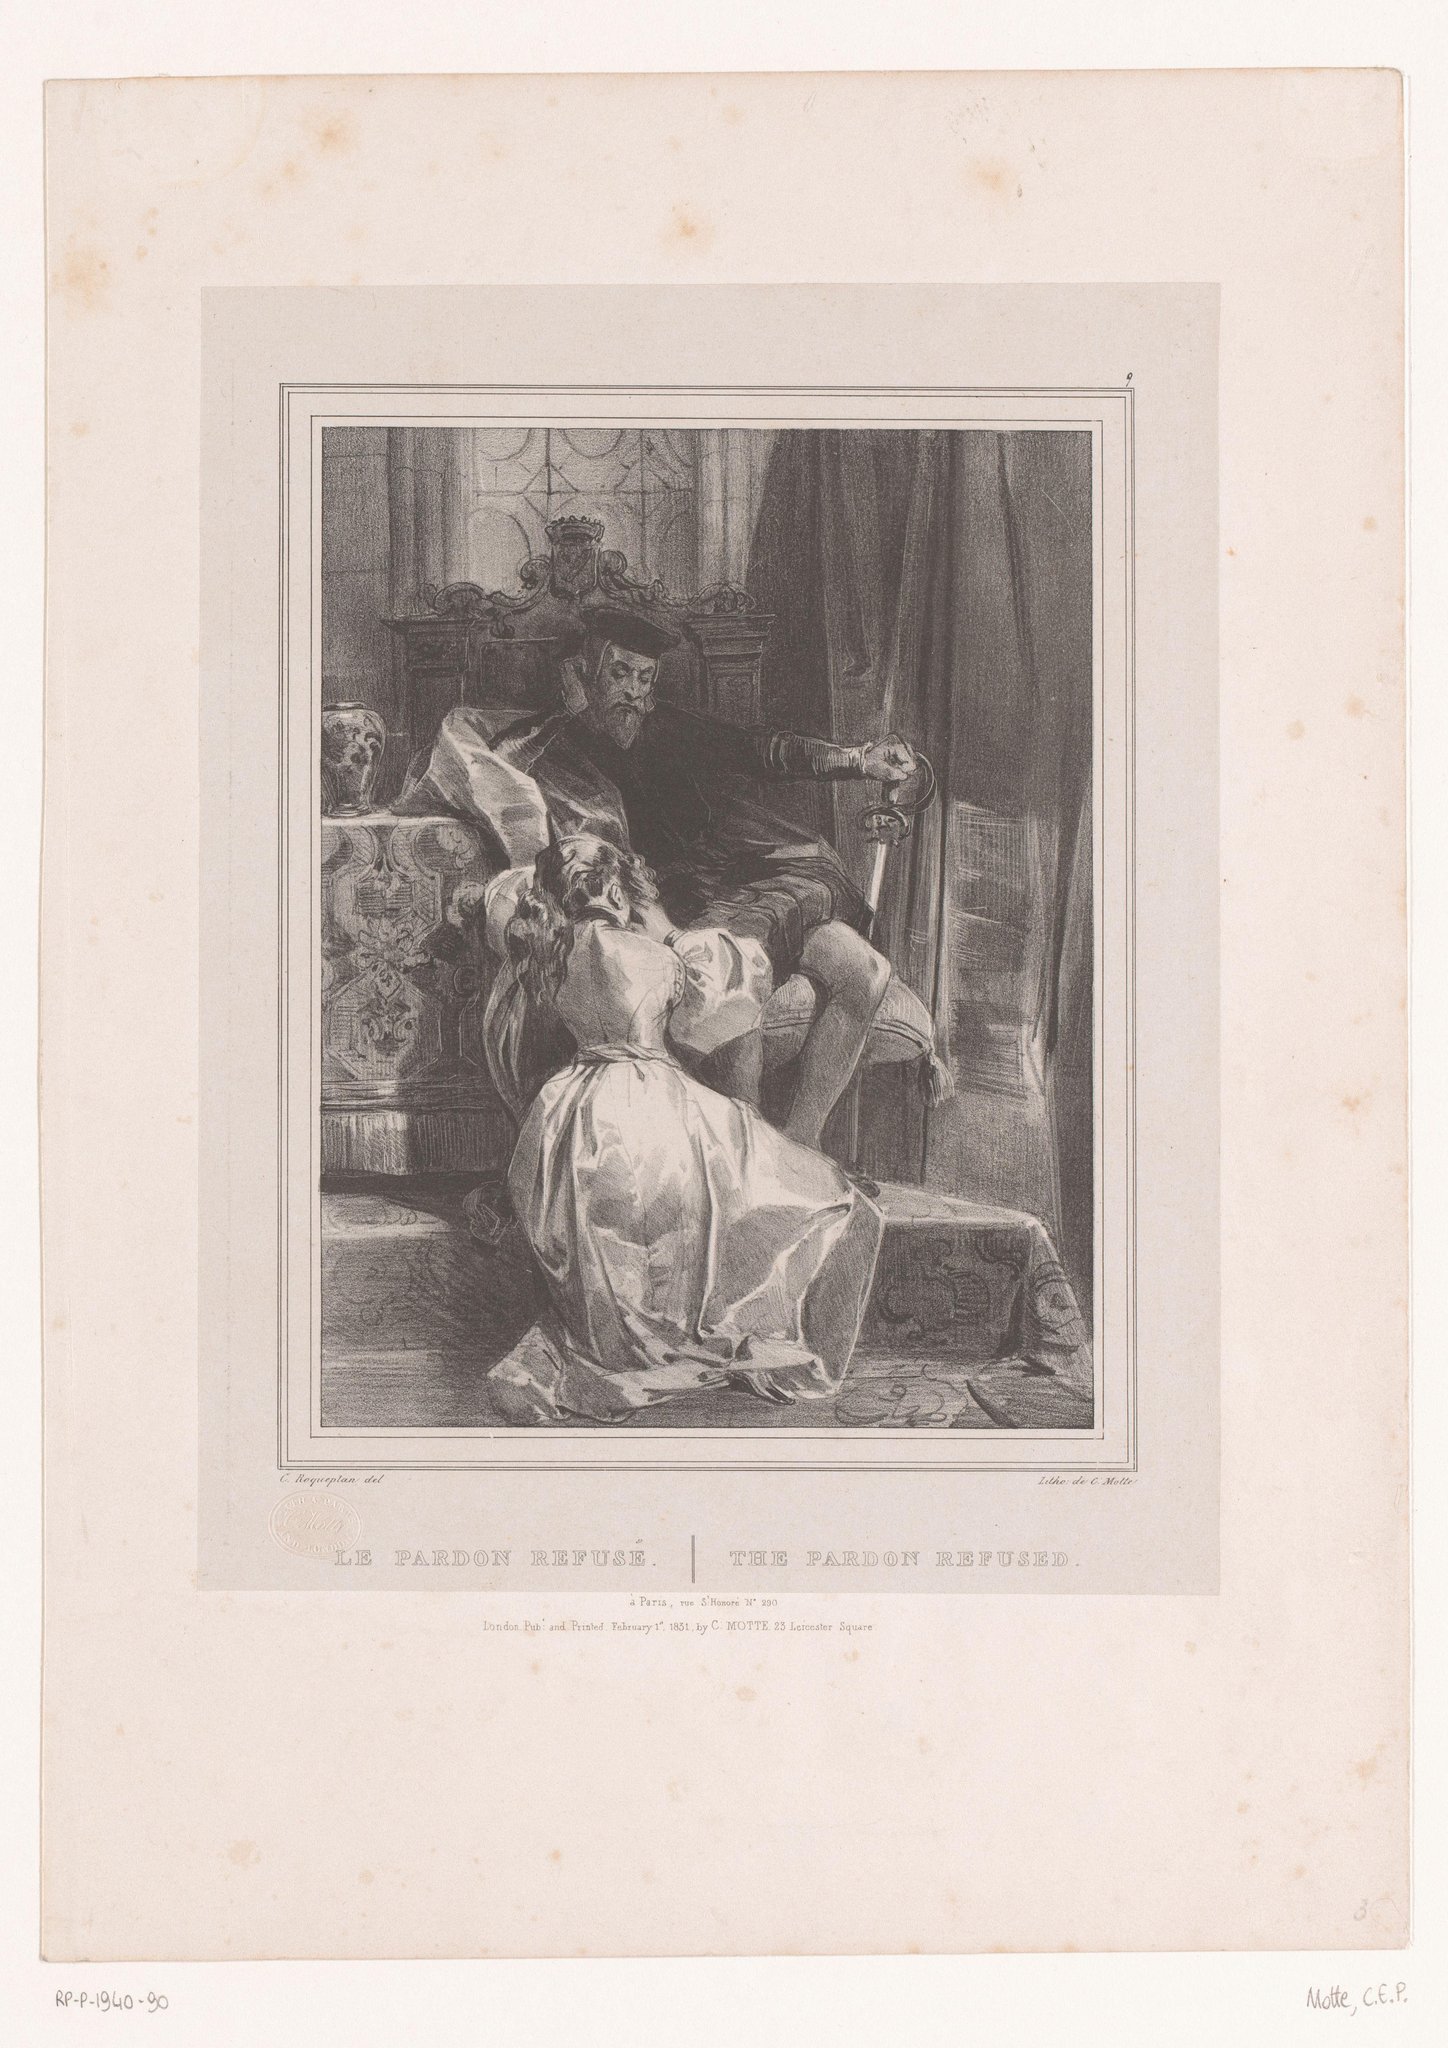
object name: print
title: Huilende dochter biedt tevergeefs haar excuses aan aan haar vader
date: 1831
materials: paper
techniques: lithograph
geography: paris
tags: father with daughter(s) (father-love), child (at home) - aa - girl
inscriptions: check stamp: Lugt 1828b, collector's mark: Lugt 2760, collector's mark: Lugt 2166